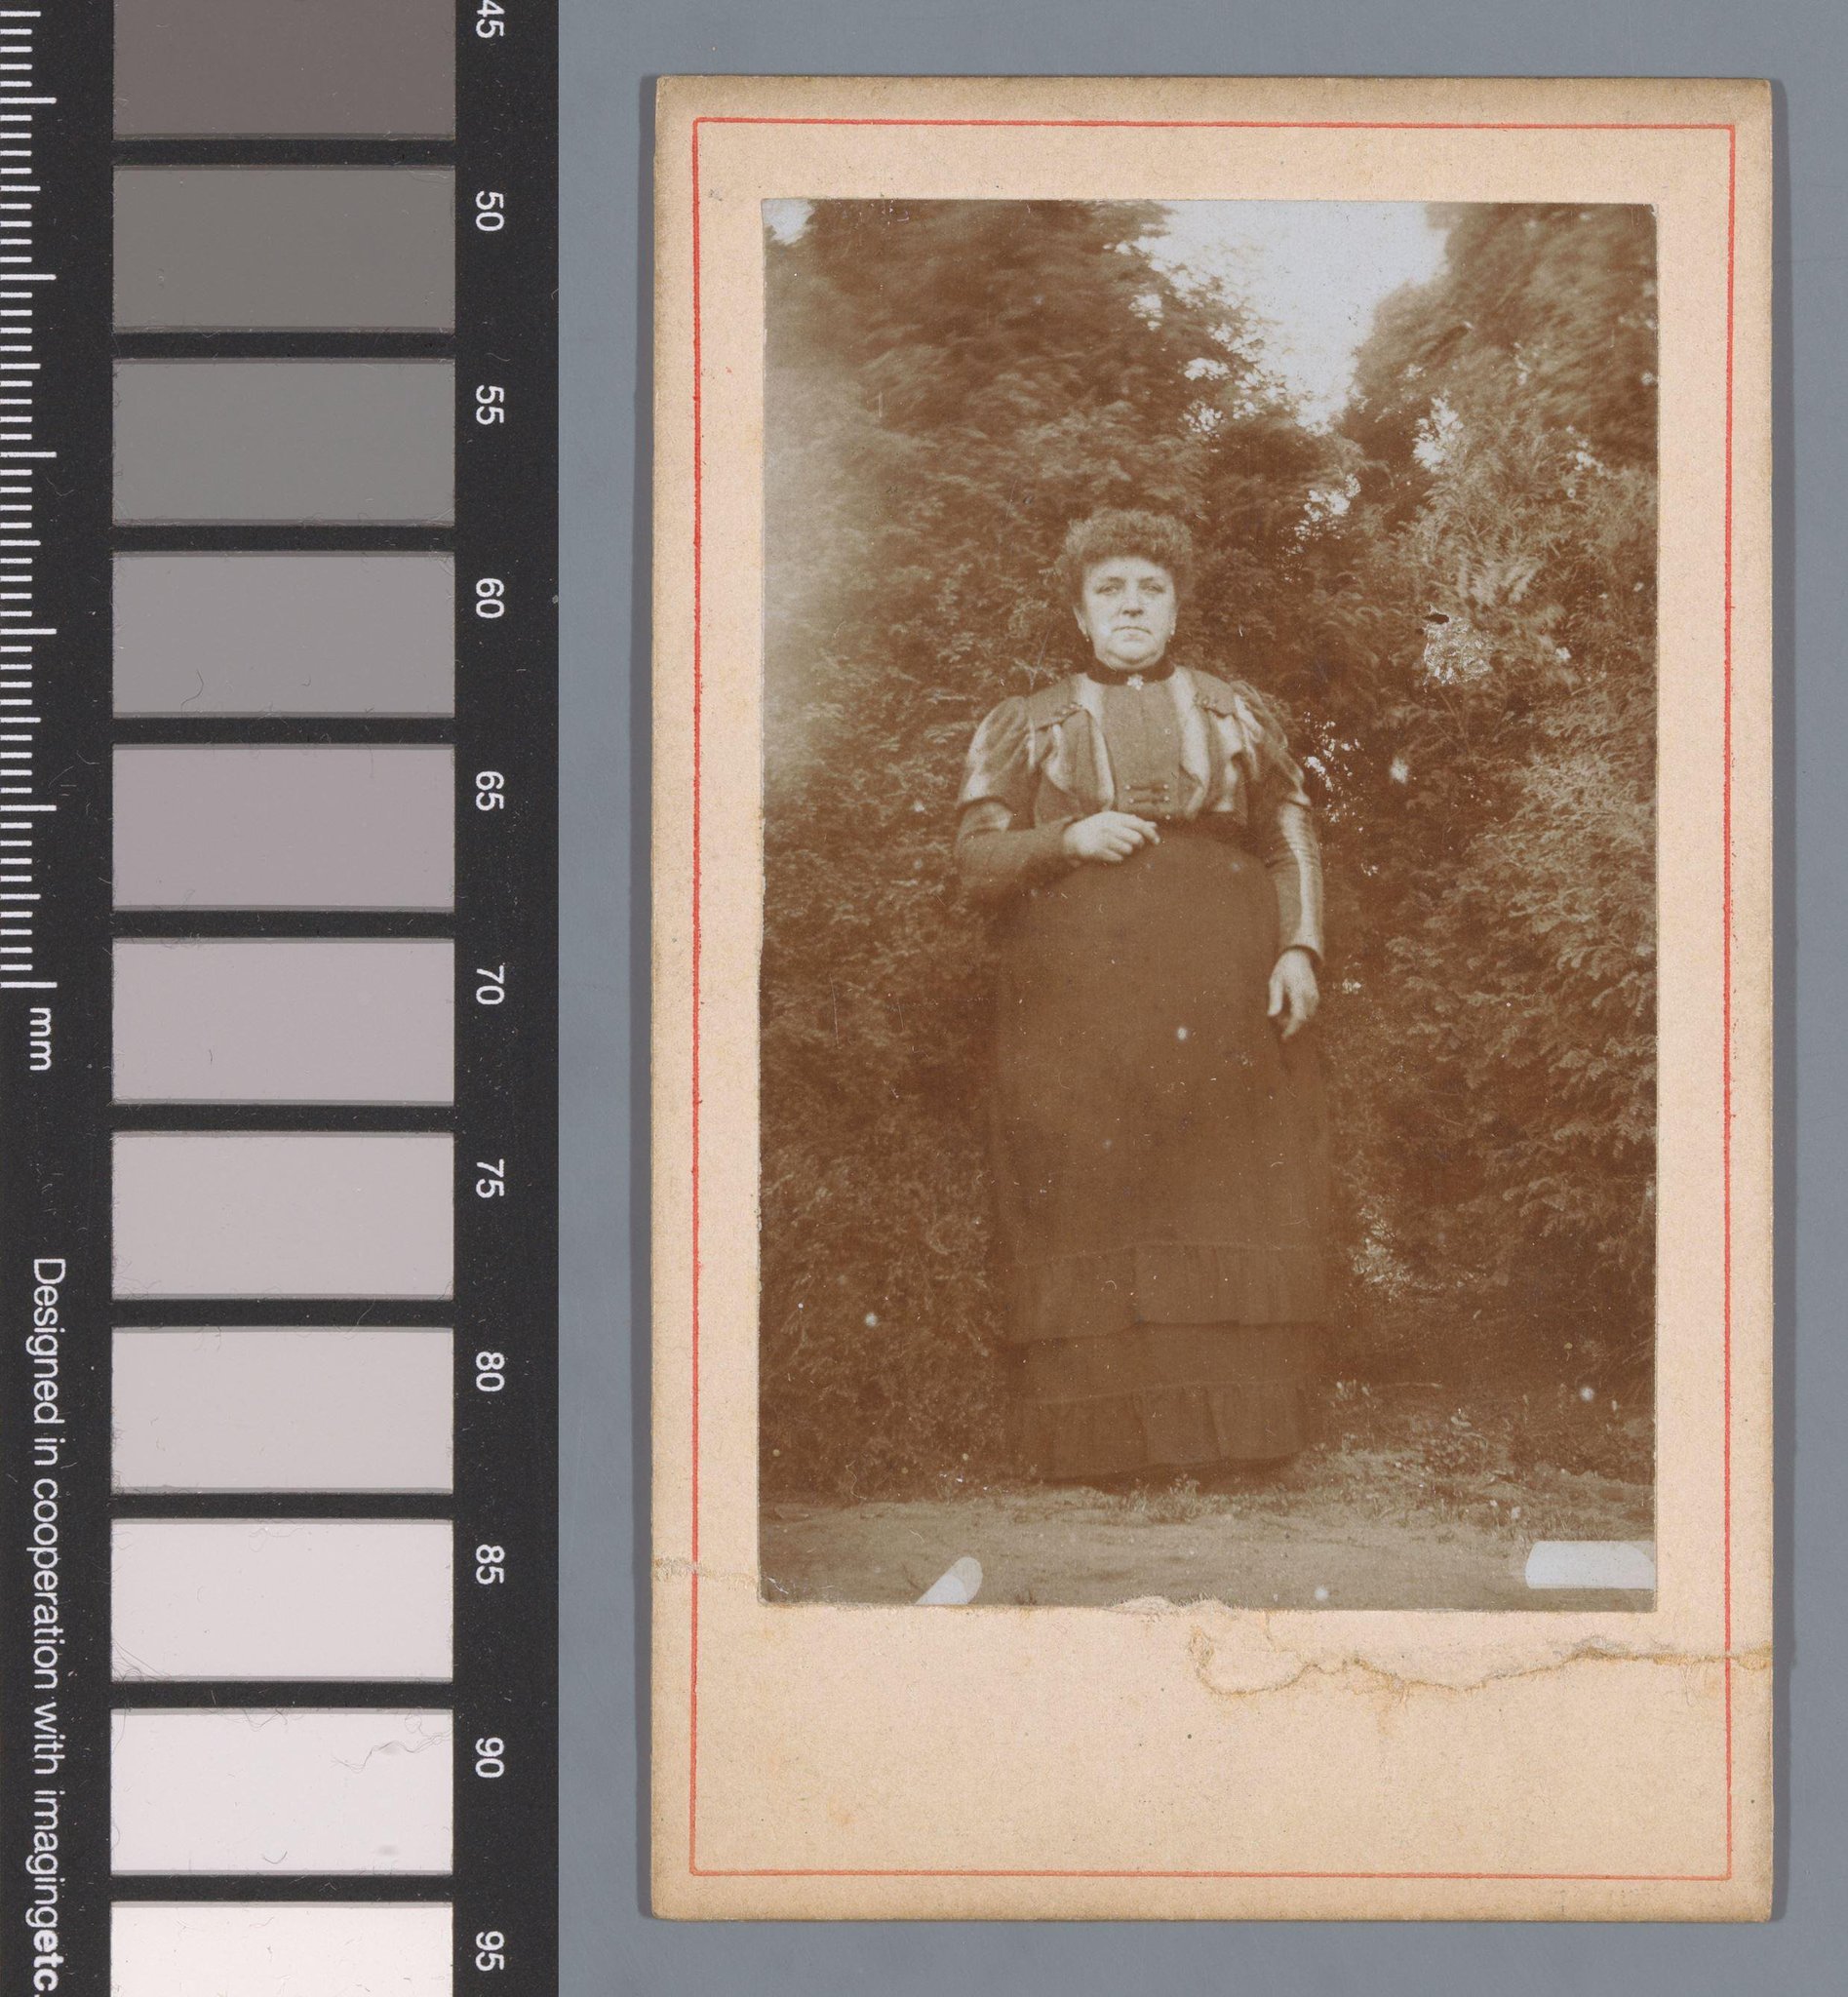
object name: carte de visite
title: Portret van een onbekende vrouw voor bomen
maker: Anonymous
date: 1880-1920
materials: cardboard, paper, photographic support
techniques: daylight paper print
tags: trees, adult woman